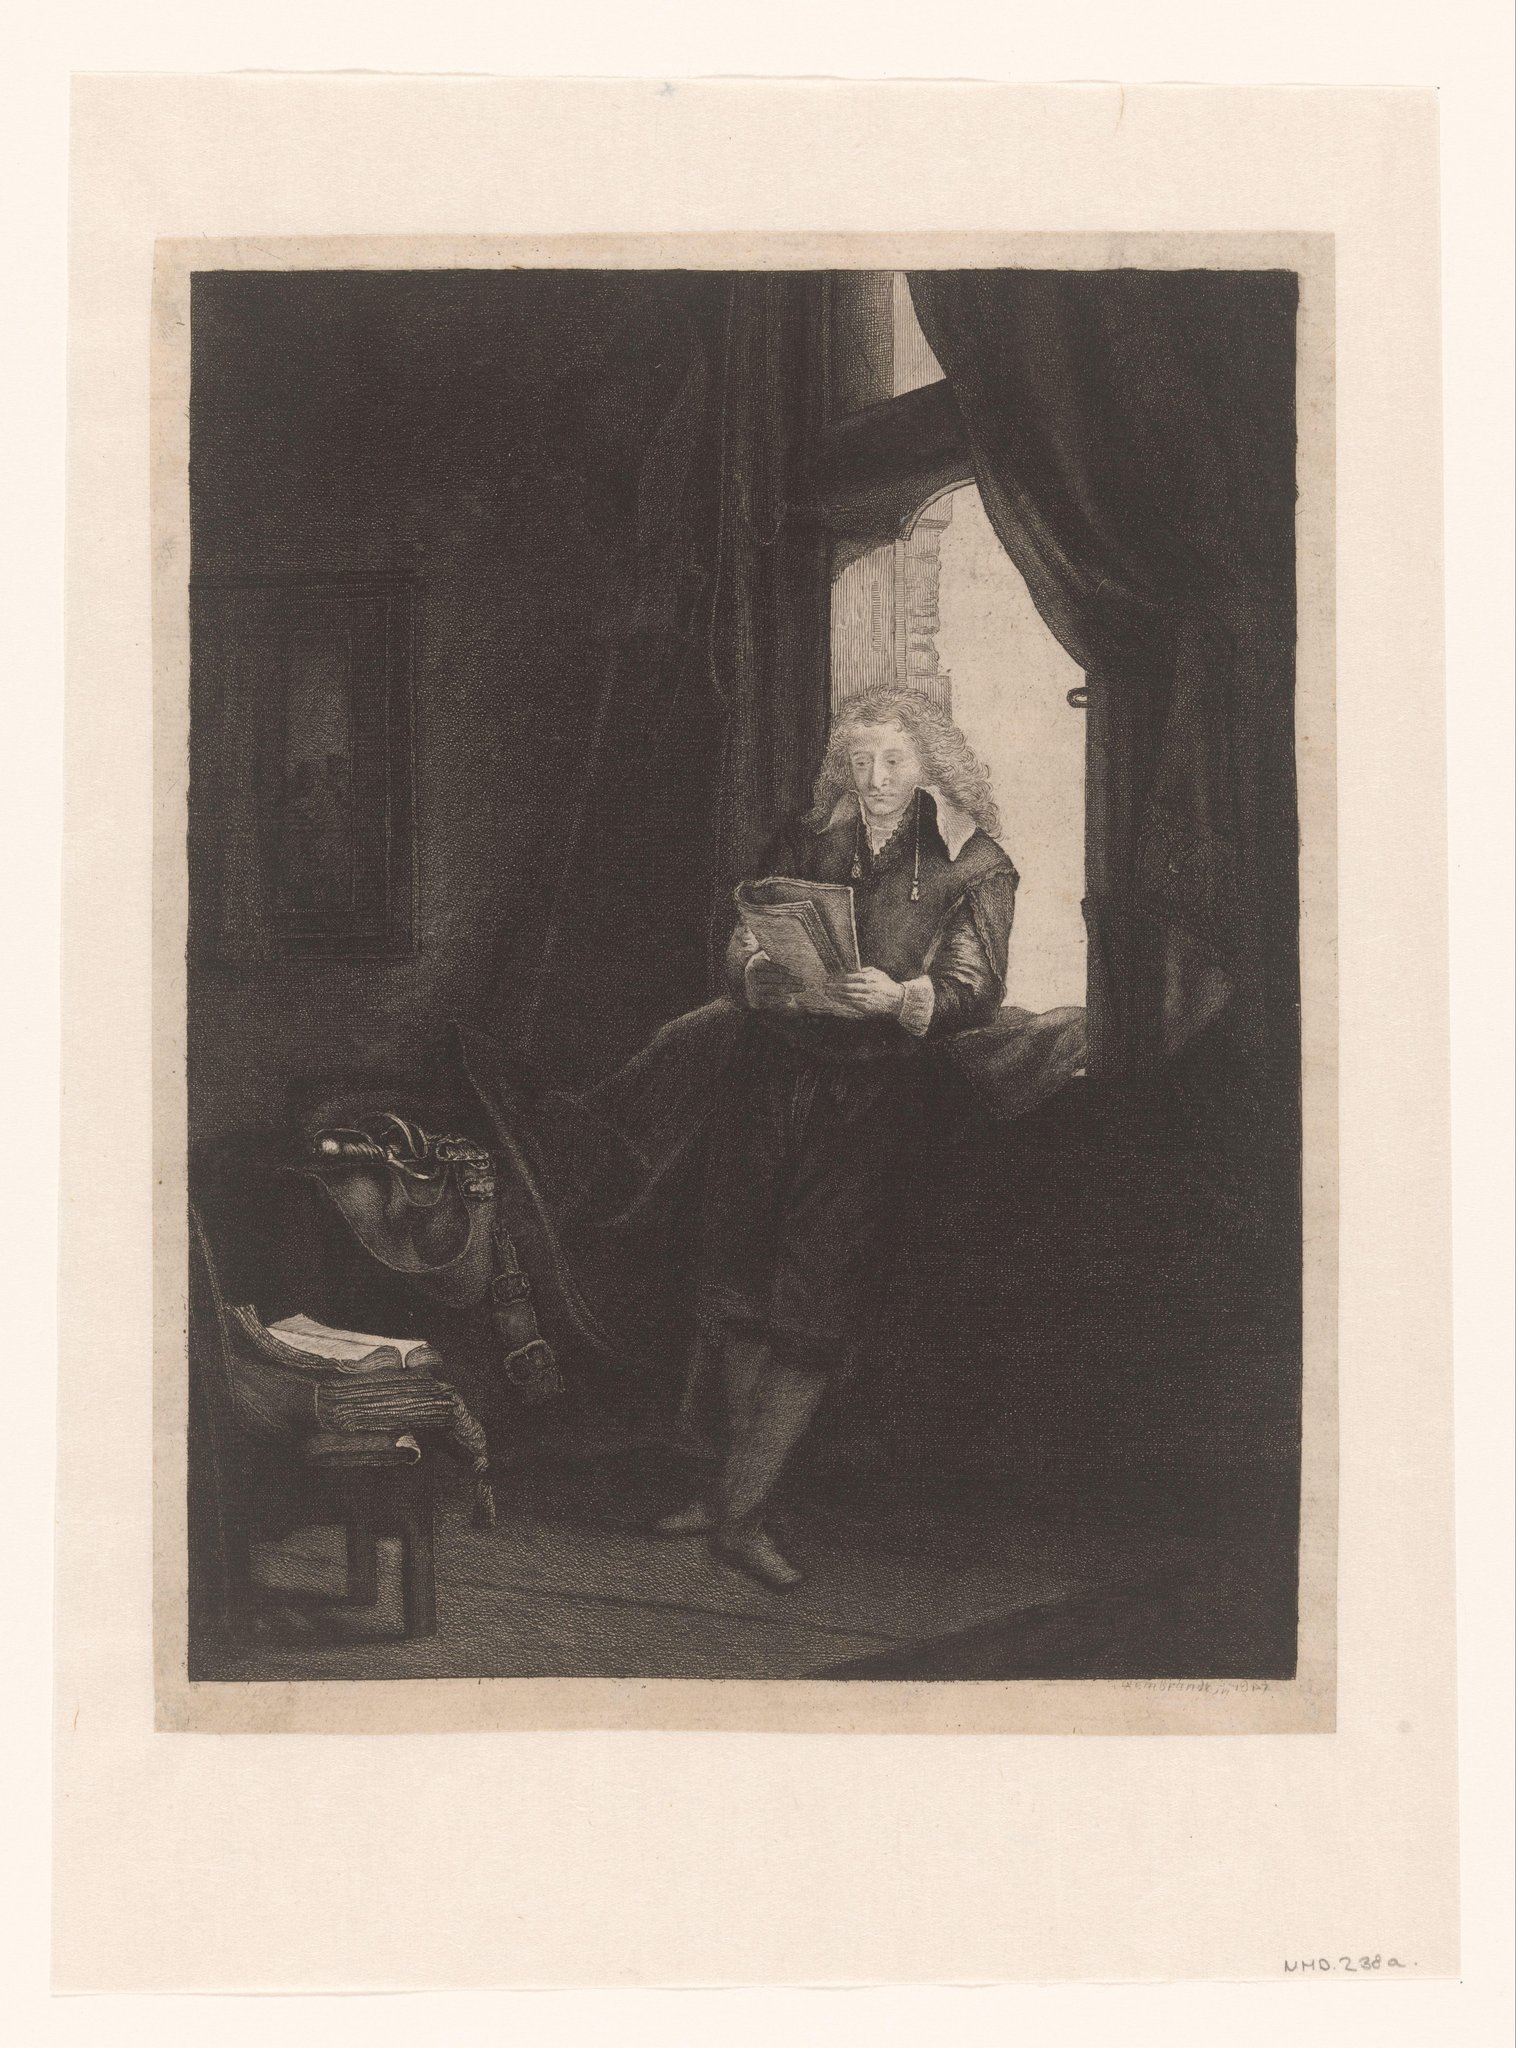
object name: print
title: Jan Six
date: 1733-1797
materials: paper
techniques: etching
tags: amsterdam, jan six (1618-1700), historical persons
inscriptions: collector's mark: Lugt 2228